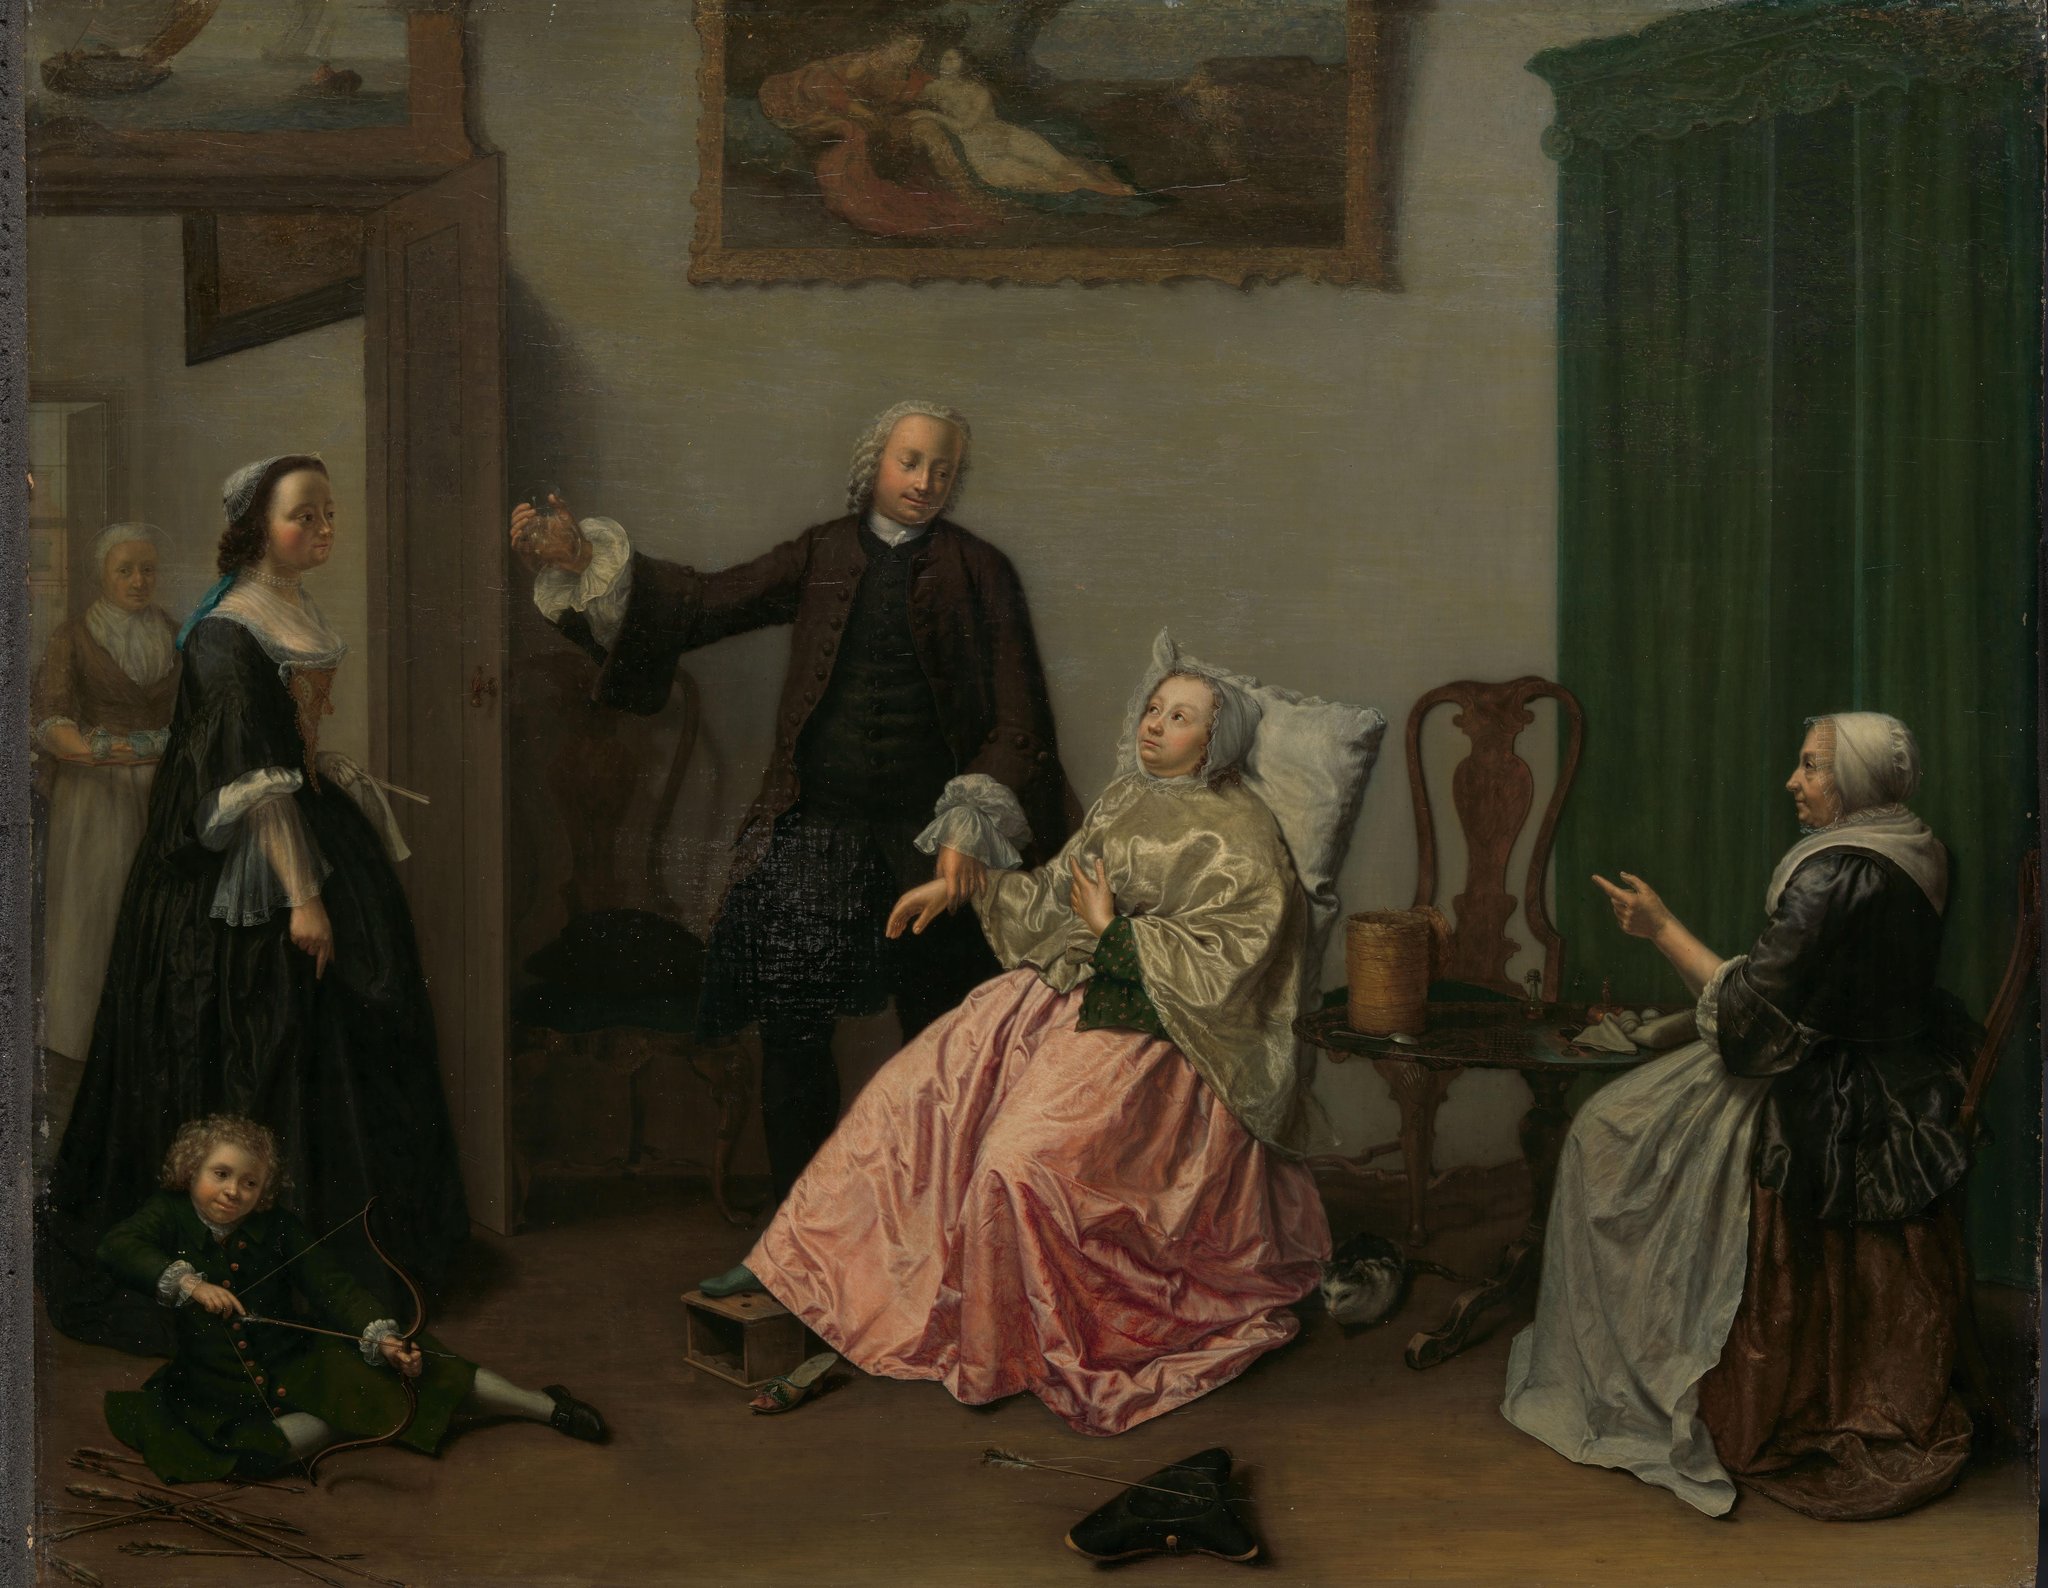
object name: painting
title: Doctor's Visit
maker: elisabeth geertruida wassenbergh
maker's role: painter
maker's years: 1729-1781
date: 1750-1760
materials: canvas, oil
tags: mischief-making play, physician, doctor, communal rooms, feeling pulse or heart-beat, shooting with bow and arrow, archery (~ games of skill), visiting the sick; sick person together with others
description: While a doctor takes the young woman’s pulse under her mother’s watchful eye, the playing boy gives away the true nature of her ailment. It is lovesickness, caused by Cupid, god of love, who shoots arrows into people’s hearts. Elisabeth Geertruida Wassenbergh from Groningen garnered much admiration for her meticulously painted daily life scenes. In this, she chose her own path, because her teacher – her father – specialized in portraits and interior scenes.